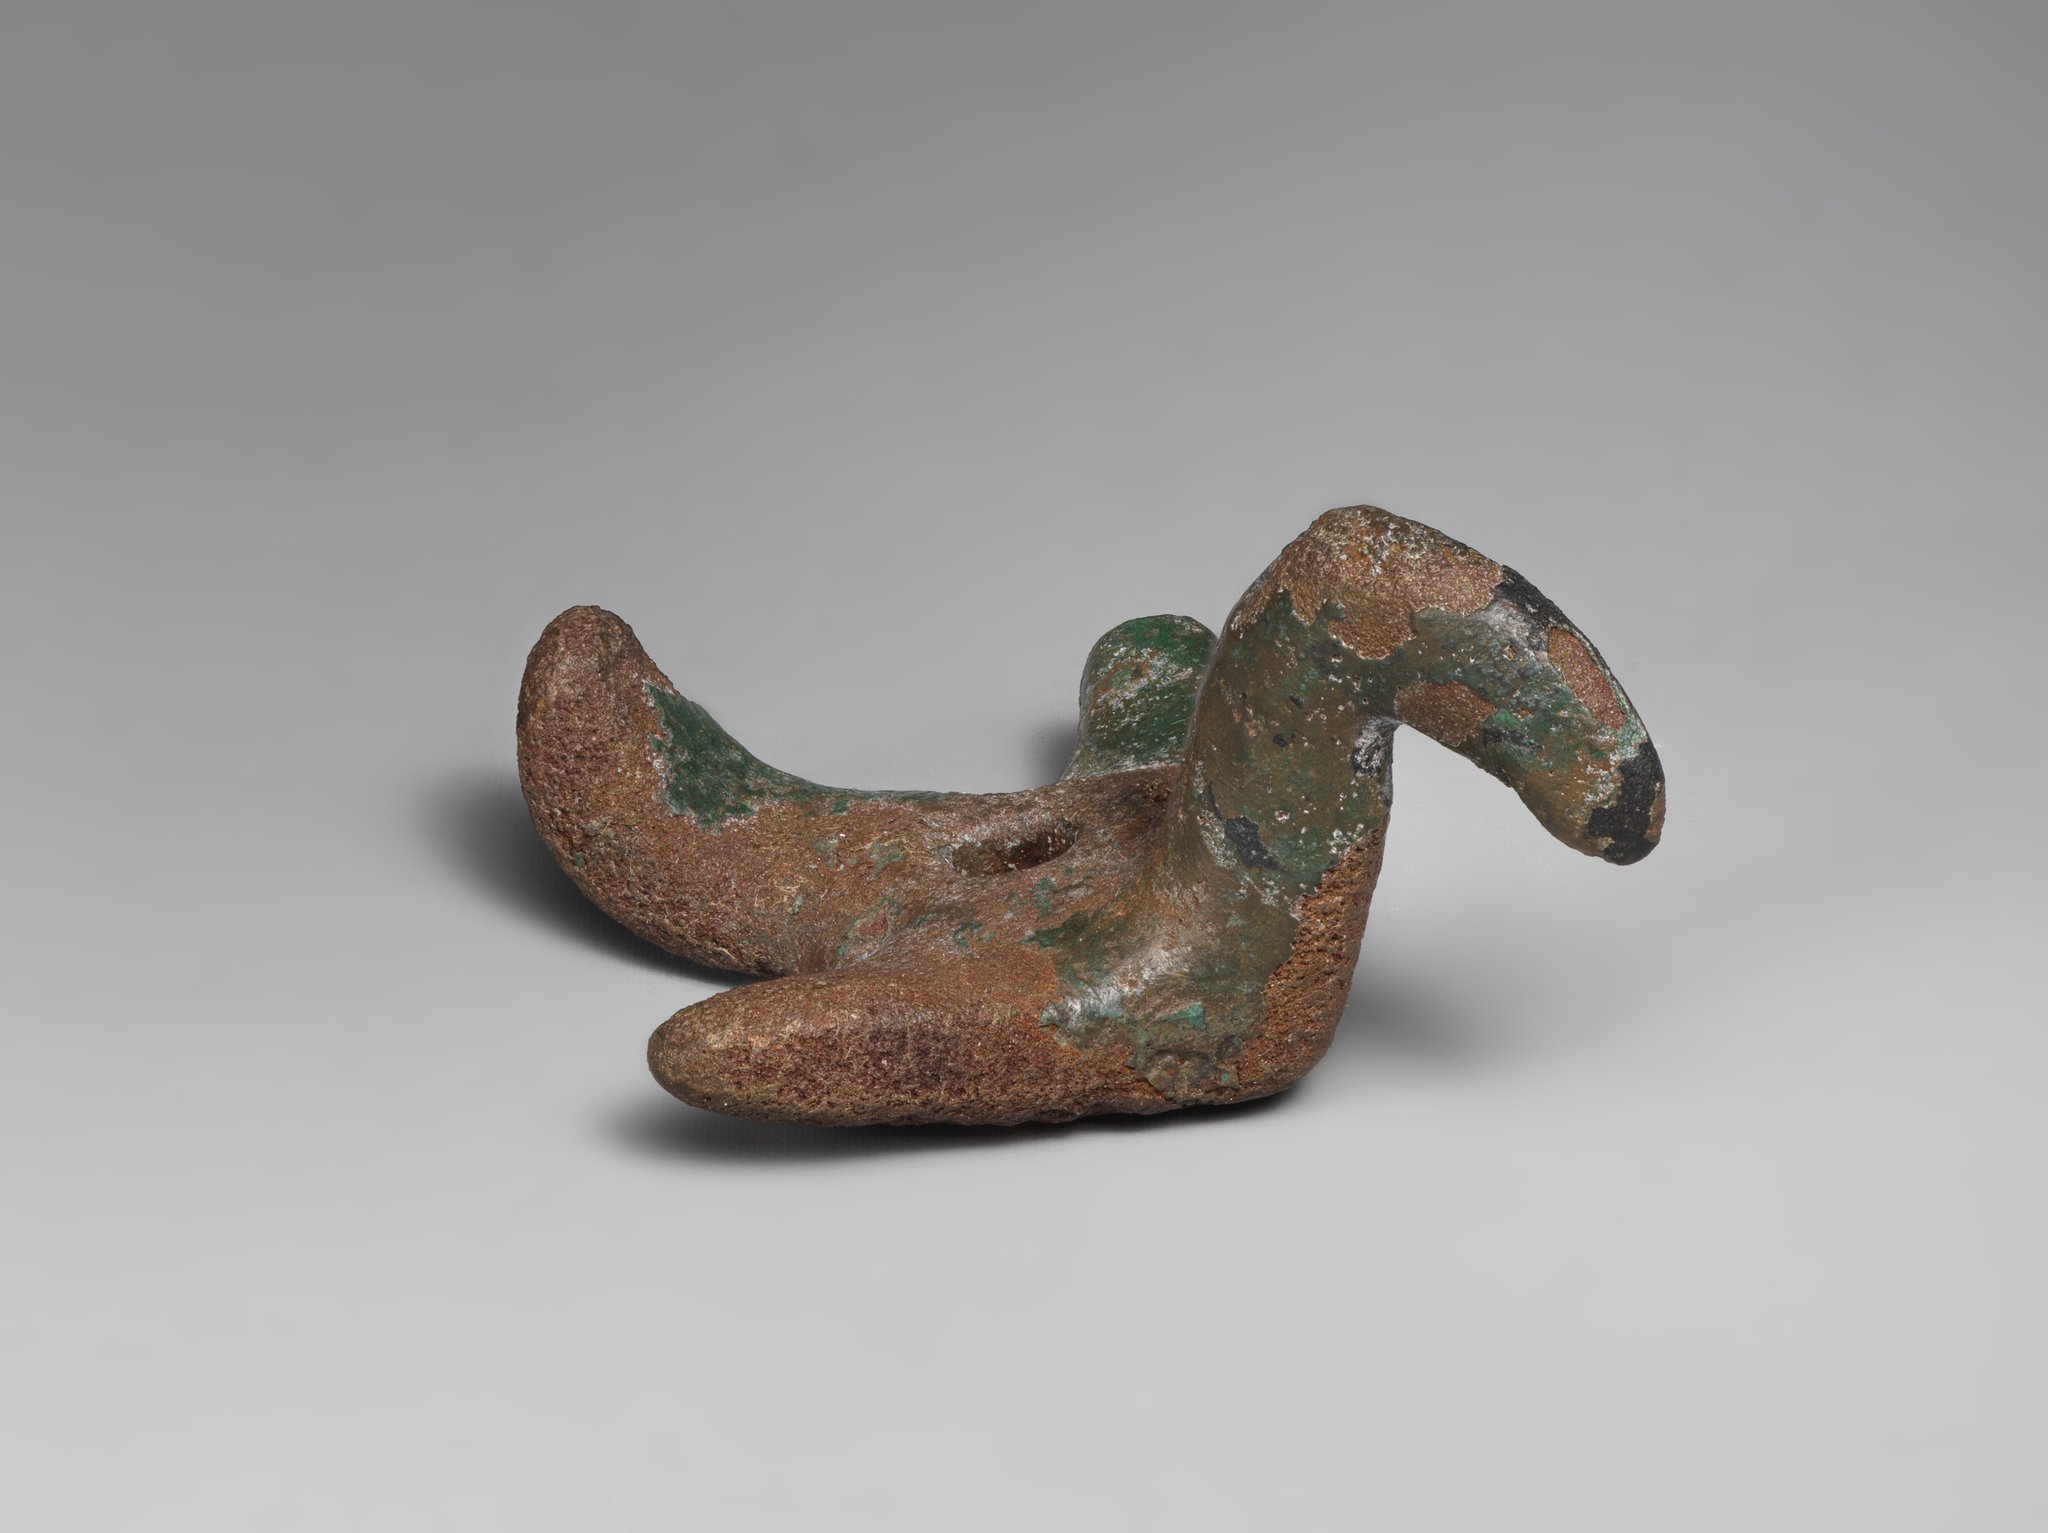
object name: pendant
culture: iranian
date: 900-801 BCE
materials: bronze, copper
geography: iran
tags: birds